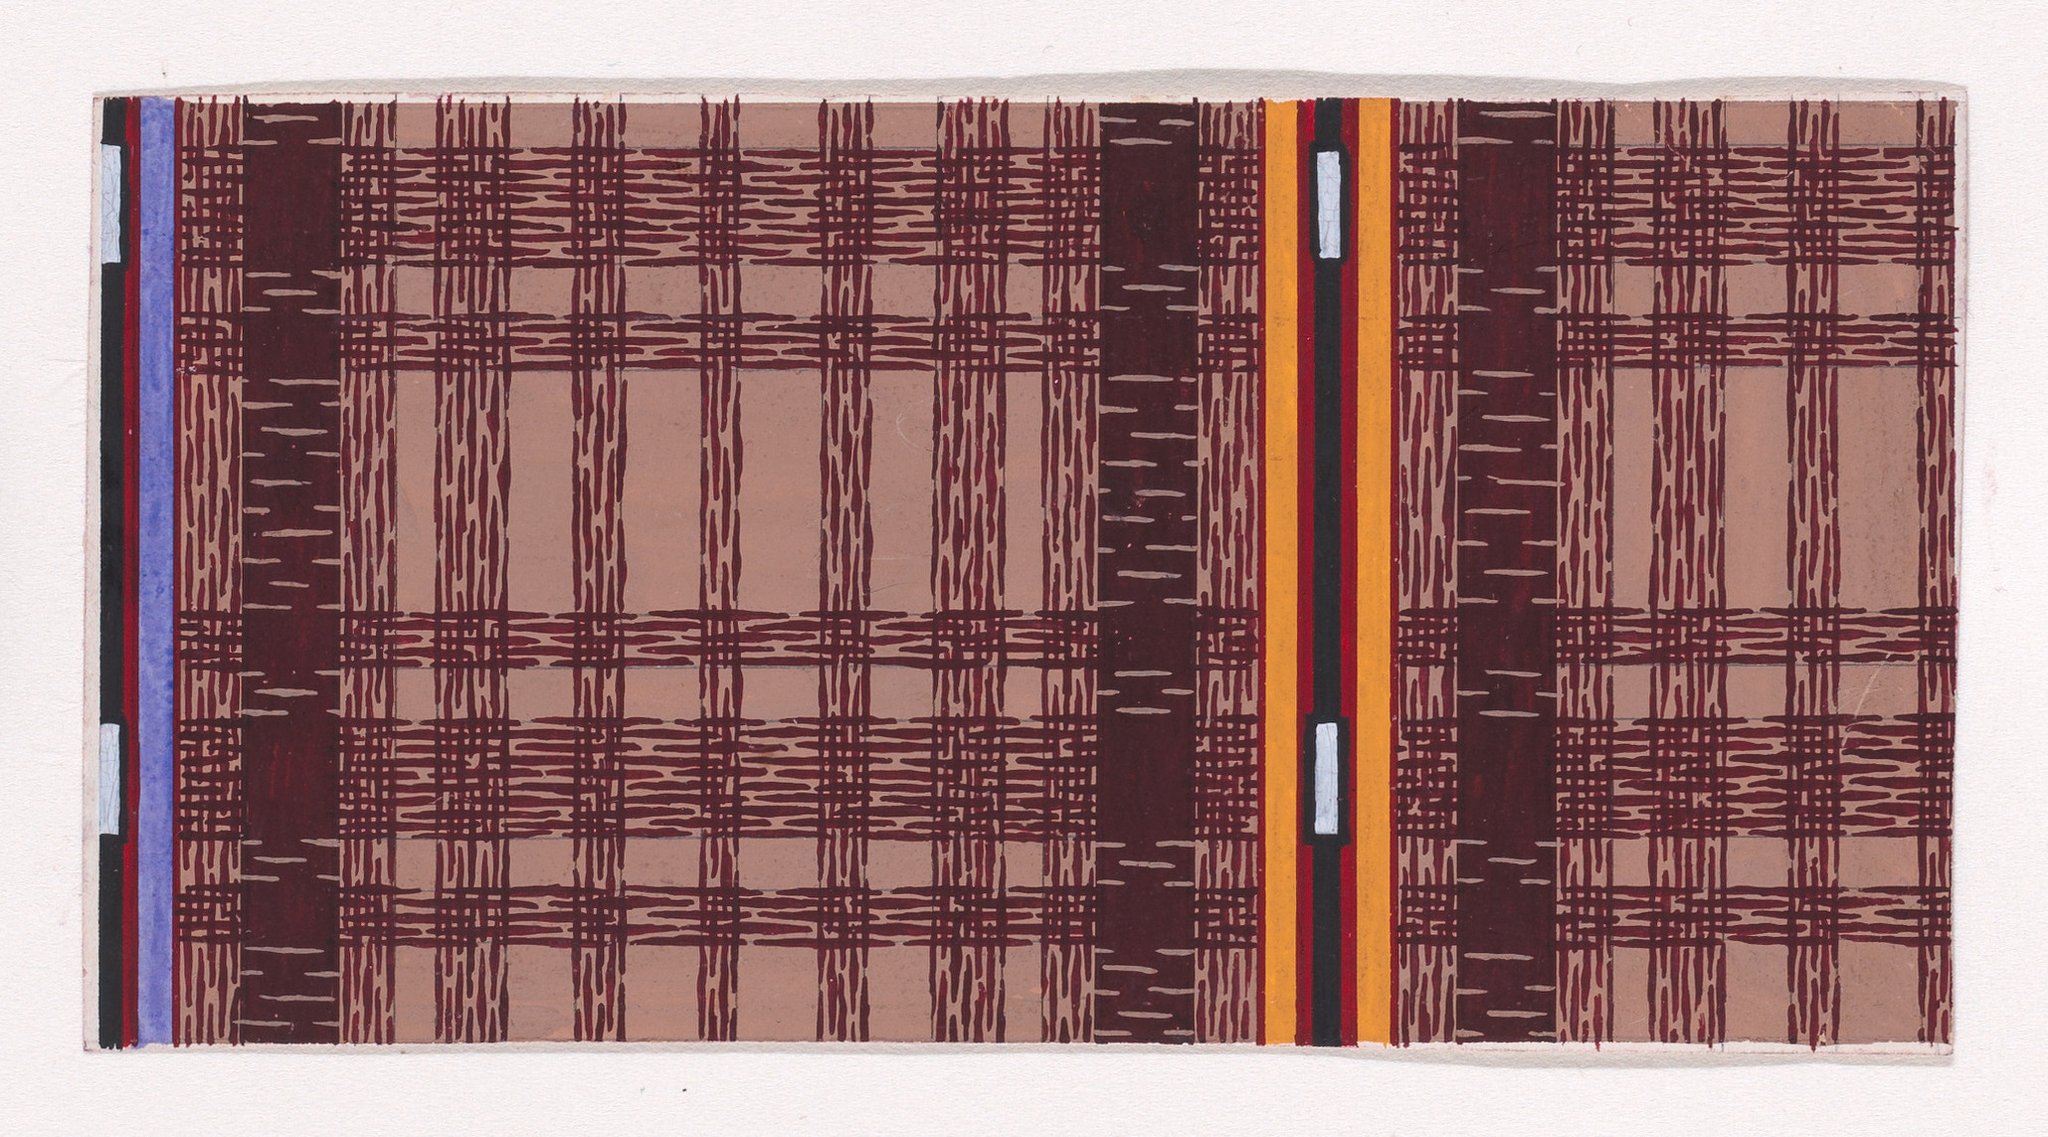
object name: drawing ornament architecture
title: Textile Design with a Tartan Pattern and Decorating Vertical Stripes of Color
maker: anonymous, alsatian, 19th century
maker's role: artist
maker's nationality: alsatian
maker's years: 1800-1900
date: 1840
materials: gouache